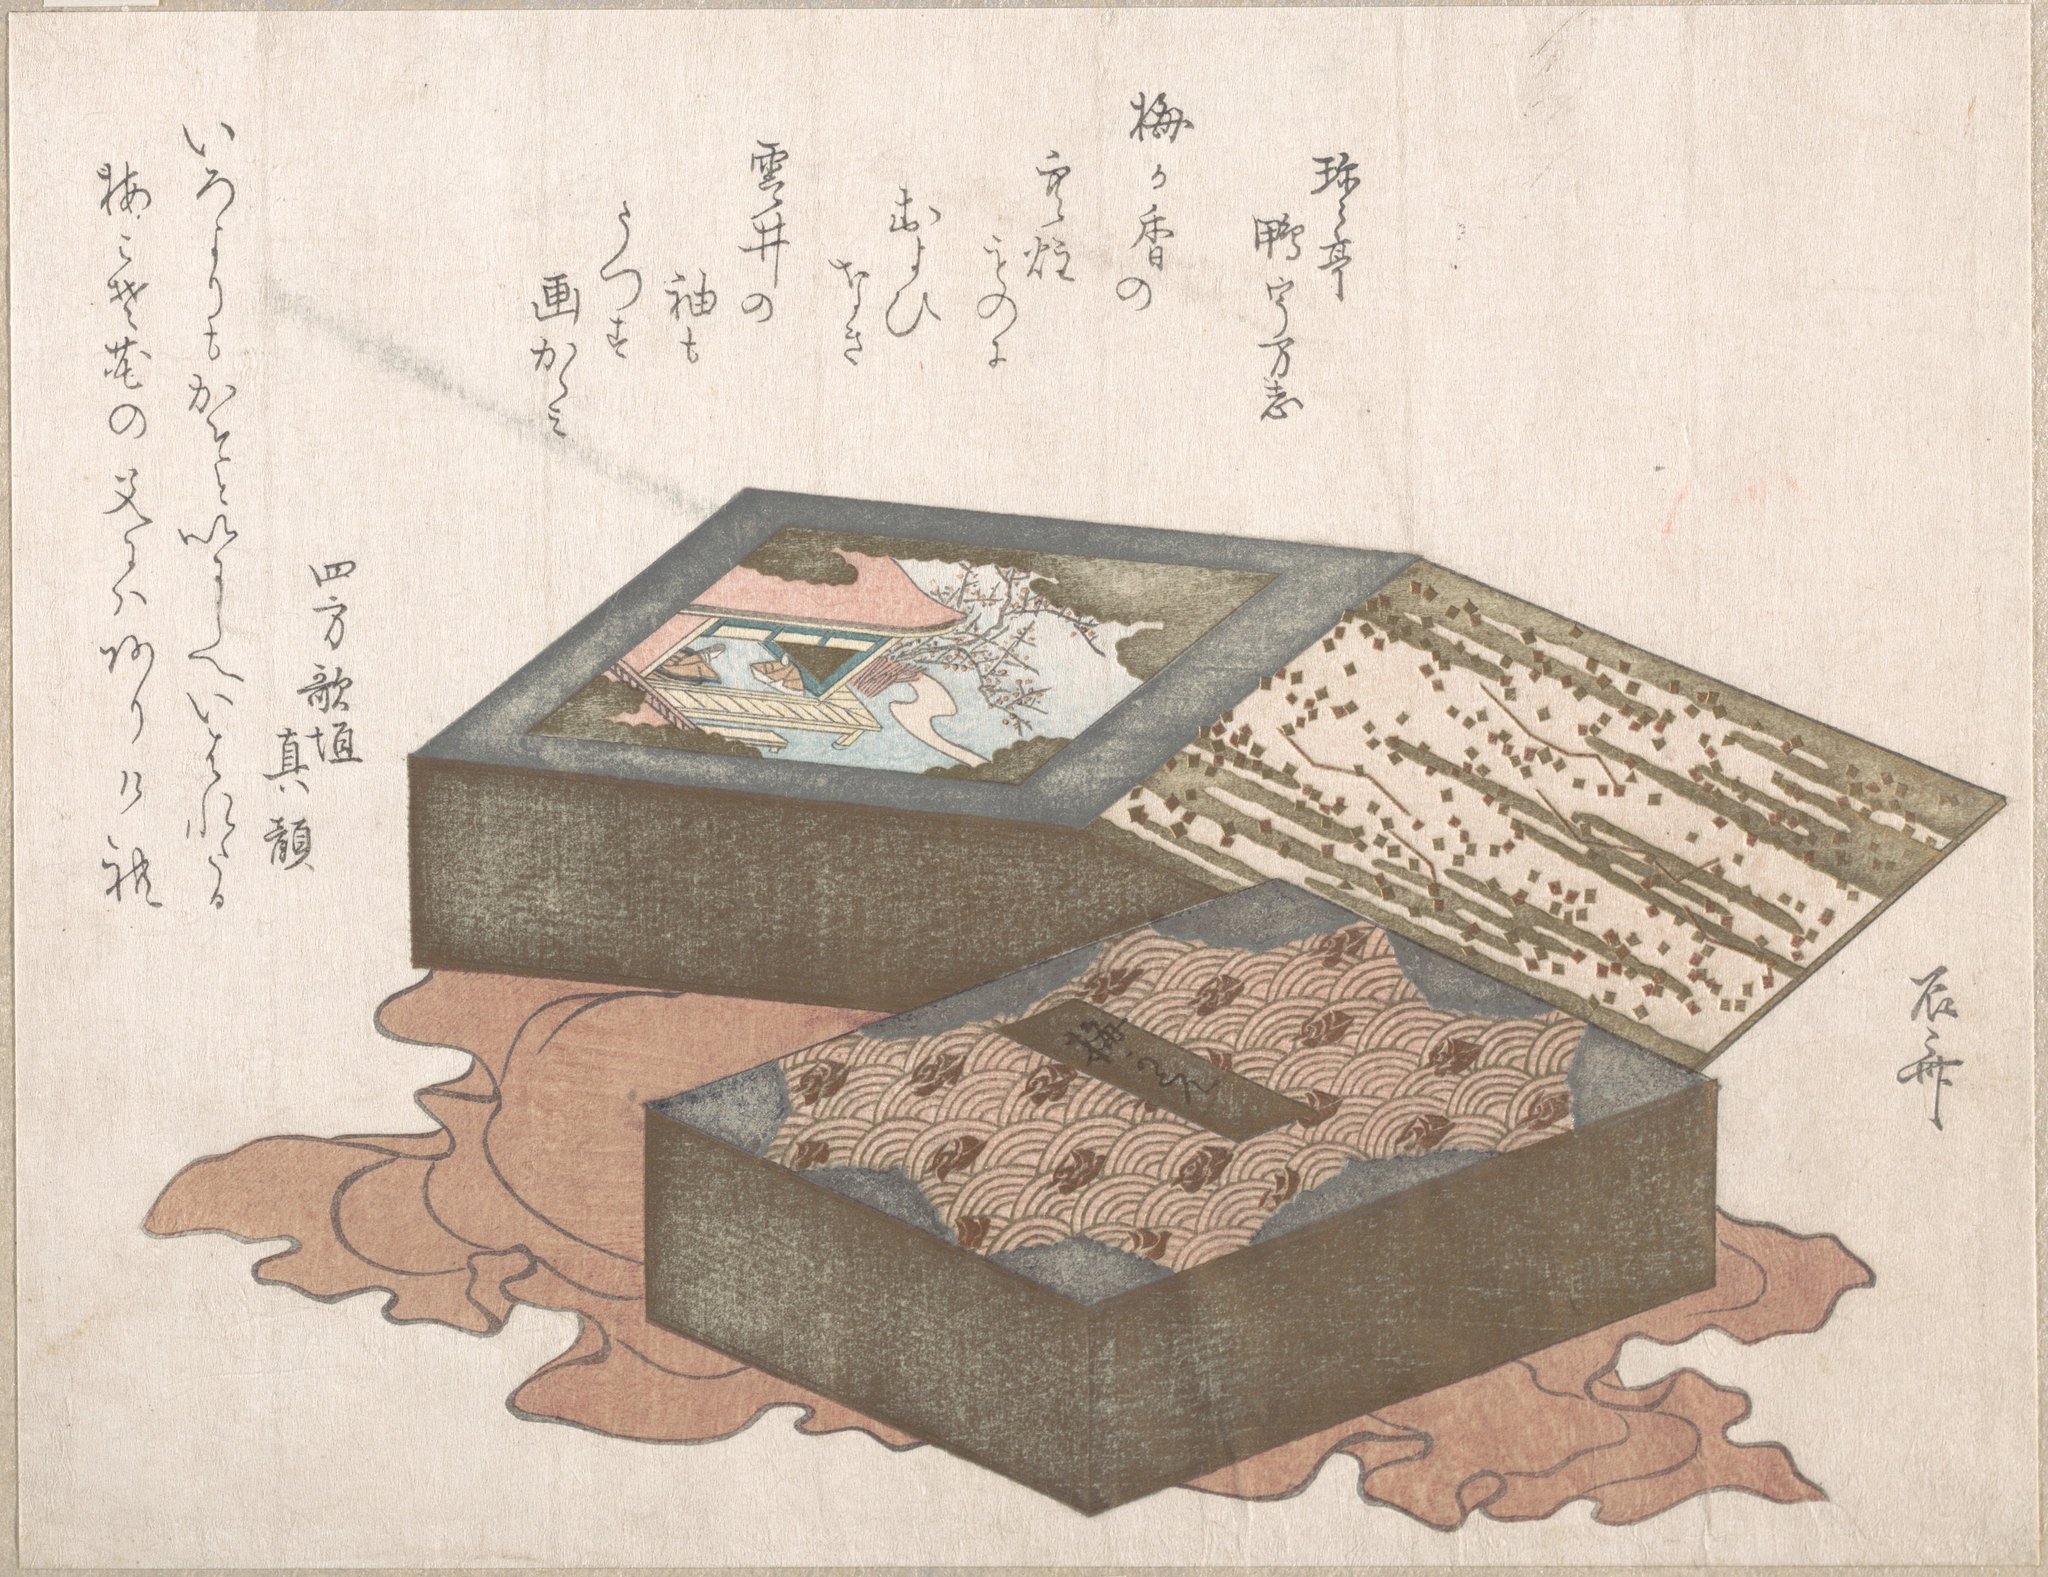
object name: woodblock print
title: Cakes In a Box with Wrapping Cloth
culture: japanese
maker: ryūryūkyo shinsai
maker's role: artist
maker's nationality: japanese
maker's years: 1799-1823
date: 1801-1900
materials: ink, paper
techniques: surimono, woodblock print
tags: food